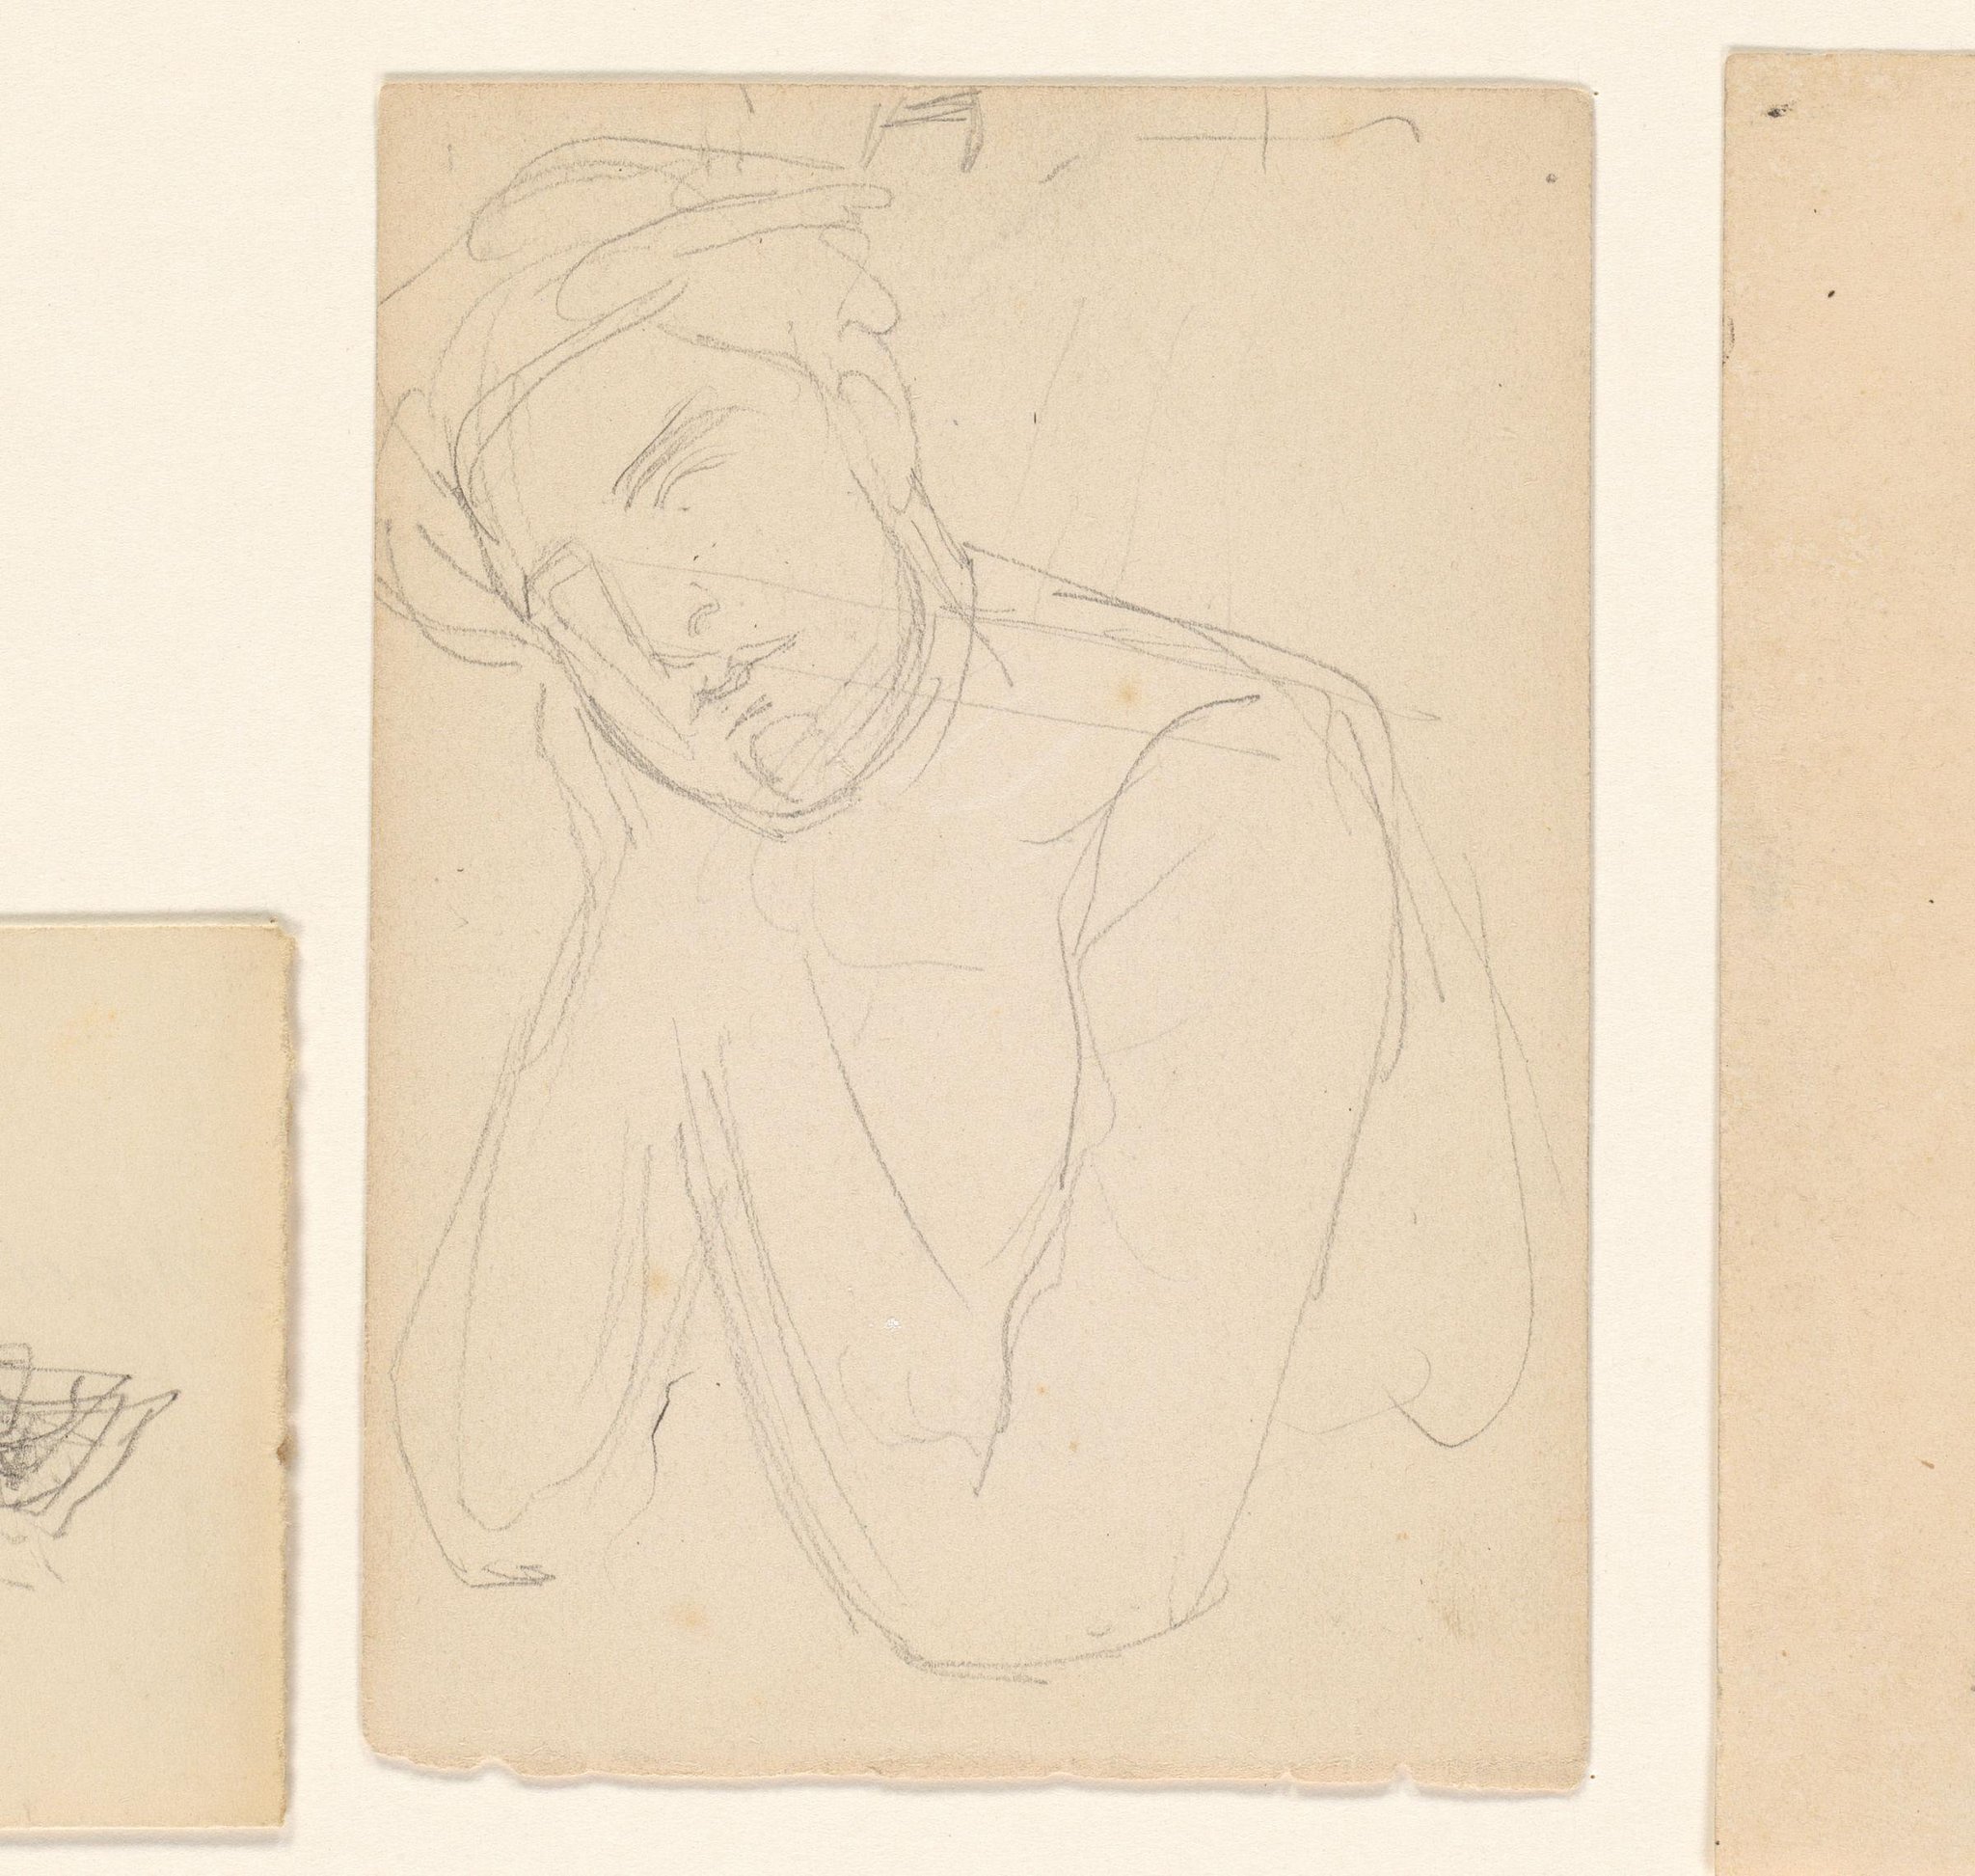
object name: drawing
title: Studie van een persoon, leunend op iets en het hoofd ondersteund met de armen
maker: august allebé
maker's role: draughtsman, print maker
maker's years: 1838-1927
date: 1848-1927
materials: paper, pencil